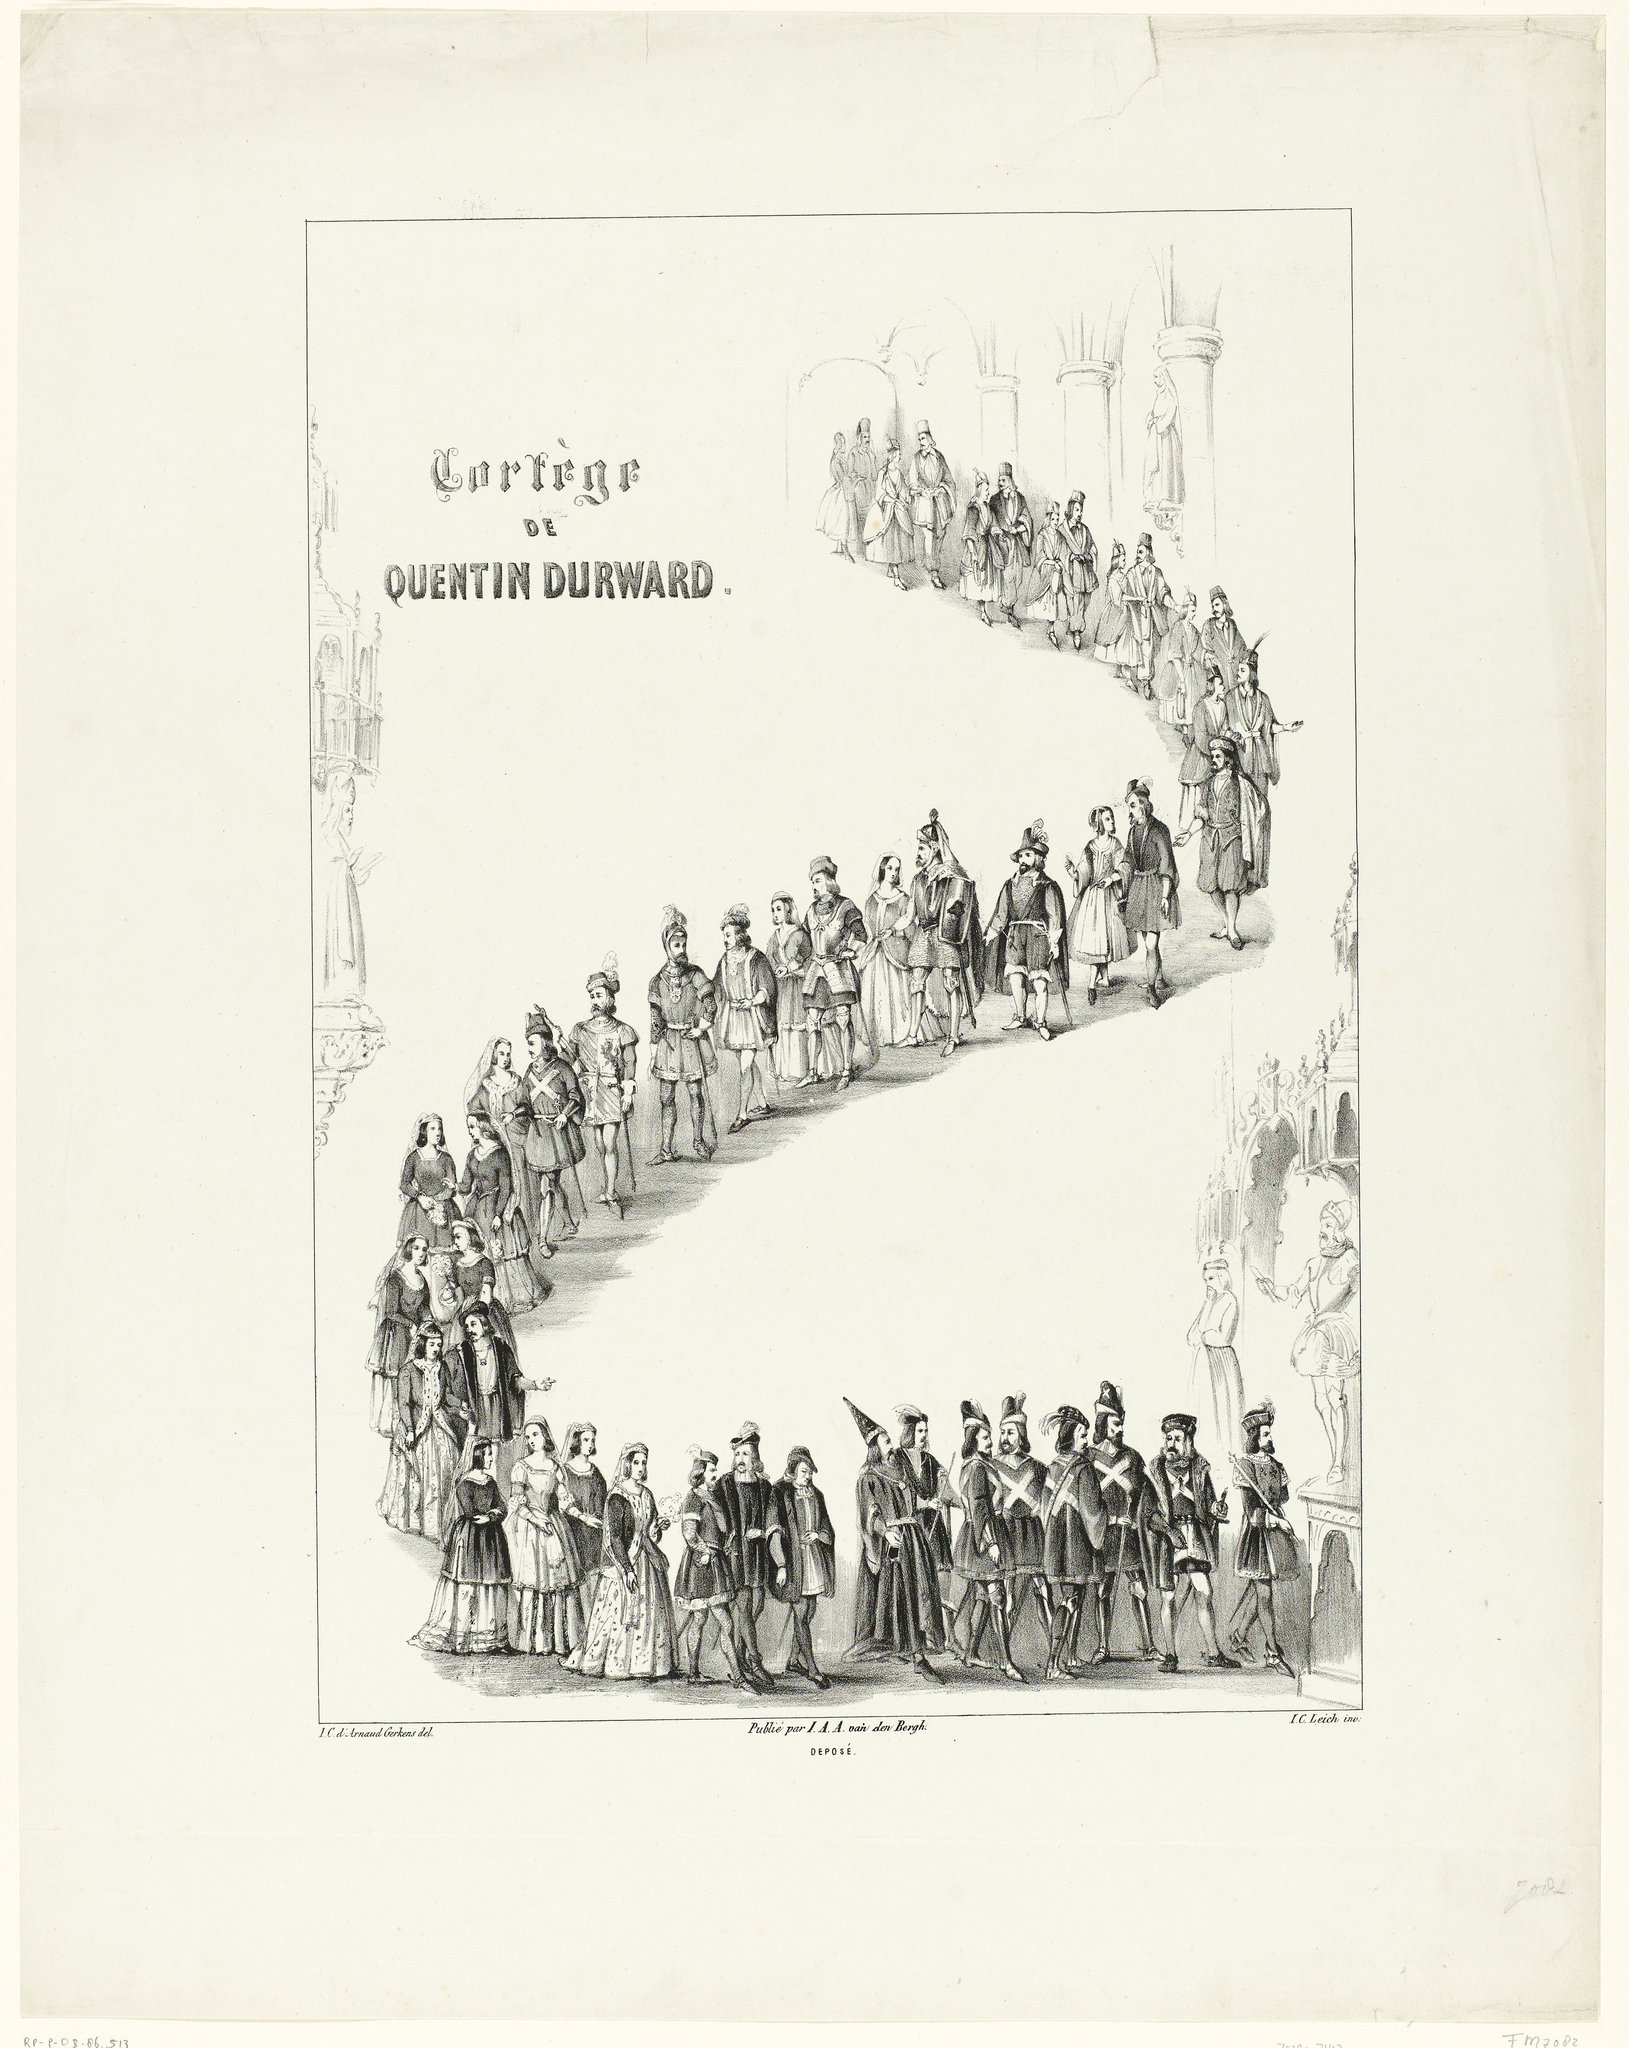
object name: costume print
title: Cortège de Quentin Durward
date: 1845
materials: paper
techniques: lithograph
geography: netherlands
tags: brussels, willem iii (koning der nederlanden), historical costume, masquerade, masked ball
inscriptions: : ‘Deposé’, collector's mark: Lugt 2228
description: Optocht van de gasten op het gekostumeerde bal gehouden op het paleis van de prins van Oranje (de latere koning Willem III) in Den Haag op 26 februari 1845. Inspiratiebron voor de middeleeuwse kostuums was de historische roman Quentin Durward van Sir Walter Scott.